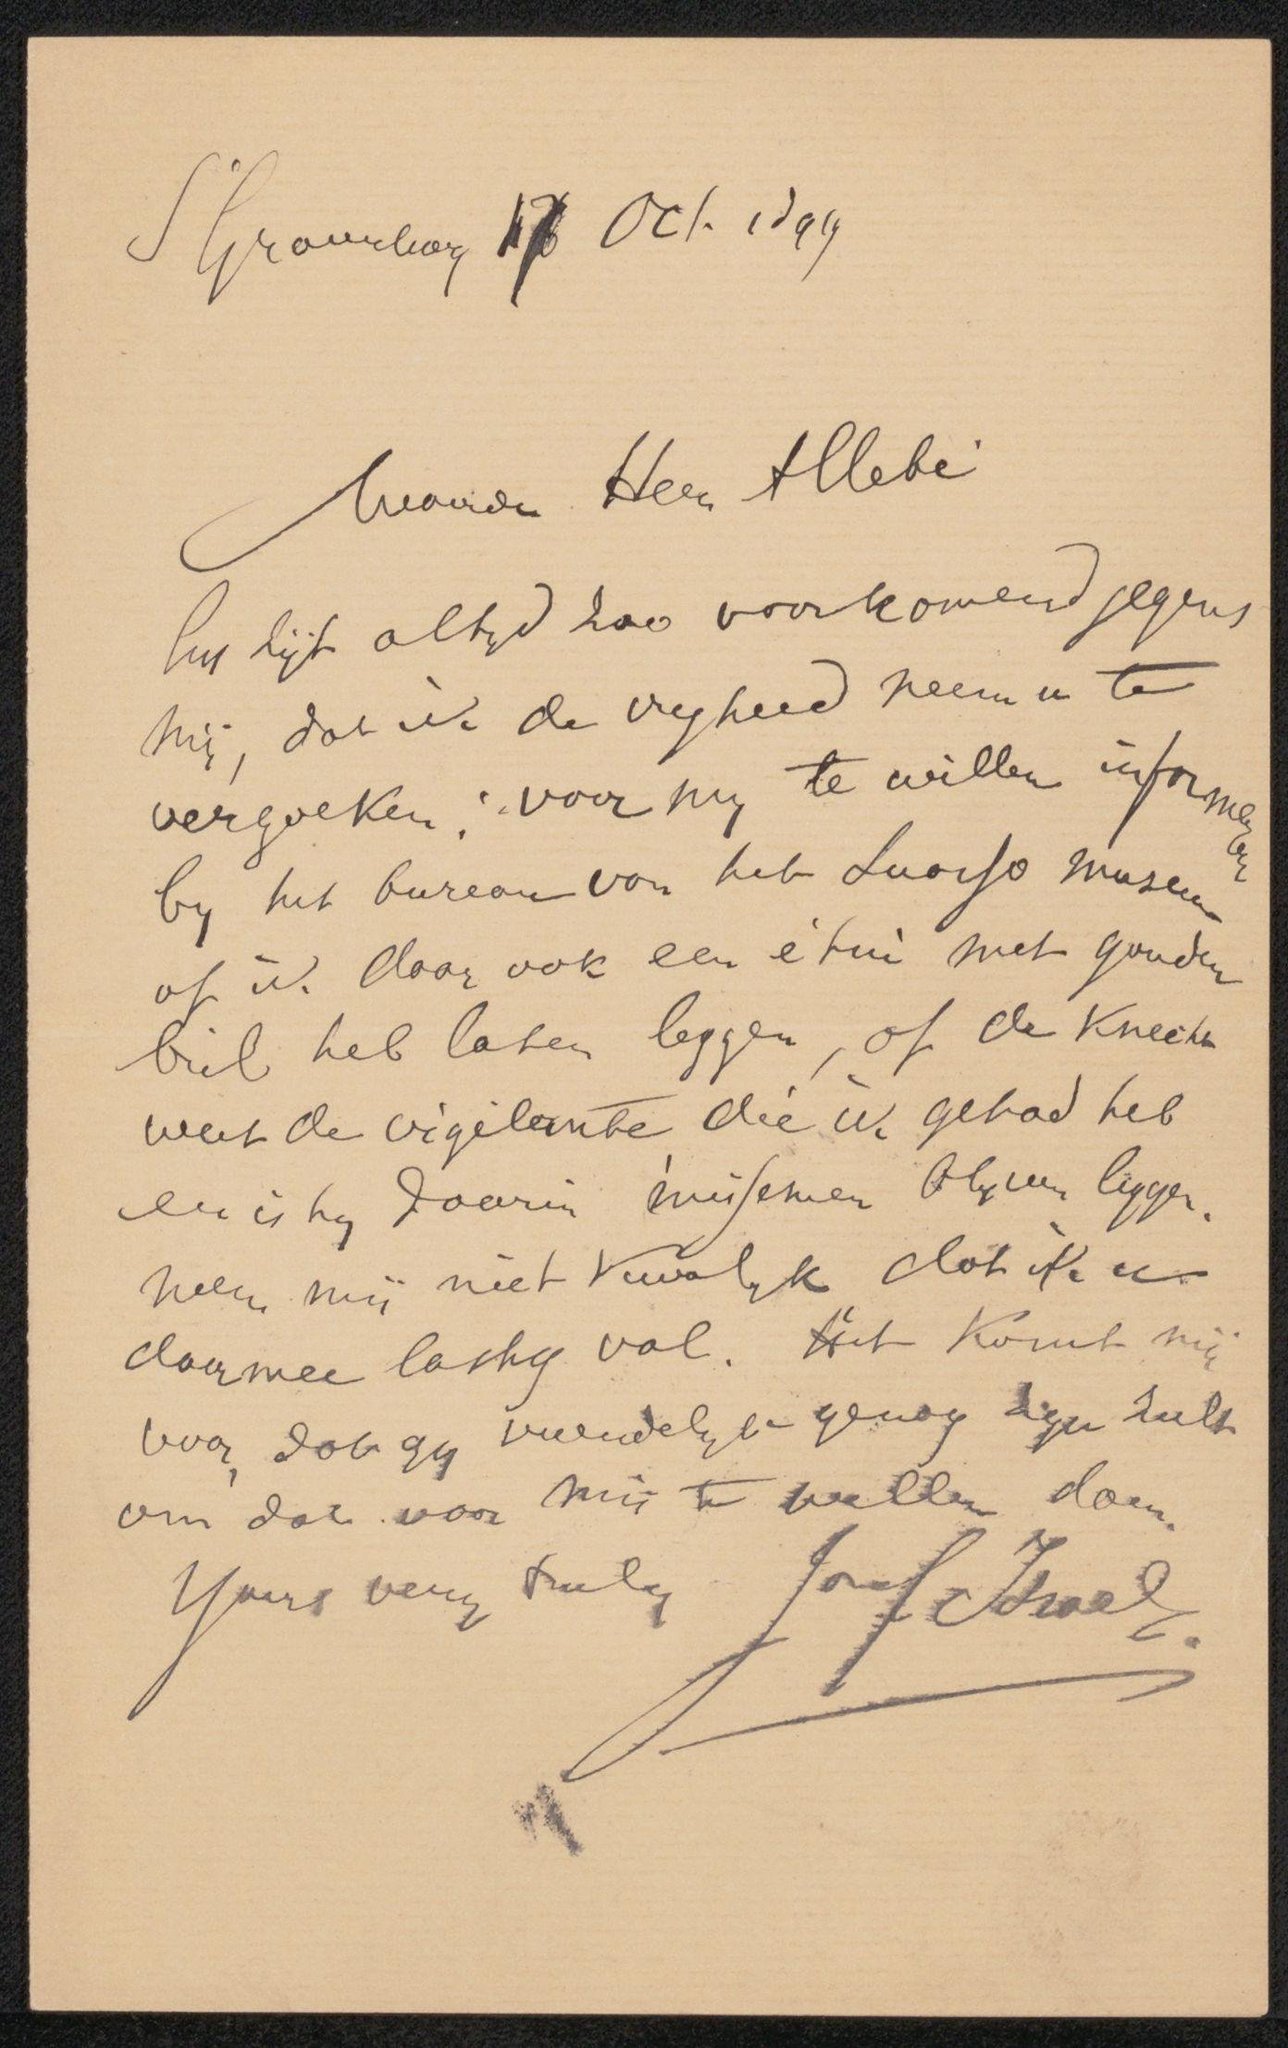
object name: letter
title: Brief aan August Allebé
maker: jozef israëls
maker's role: draughtsman, painter, print maker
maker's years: 1824-1911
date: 1899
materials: ink, paper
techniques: pen, writing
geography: the hague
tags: amsterdam, august allebé, museum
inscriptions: watermark